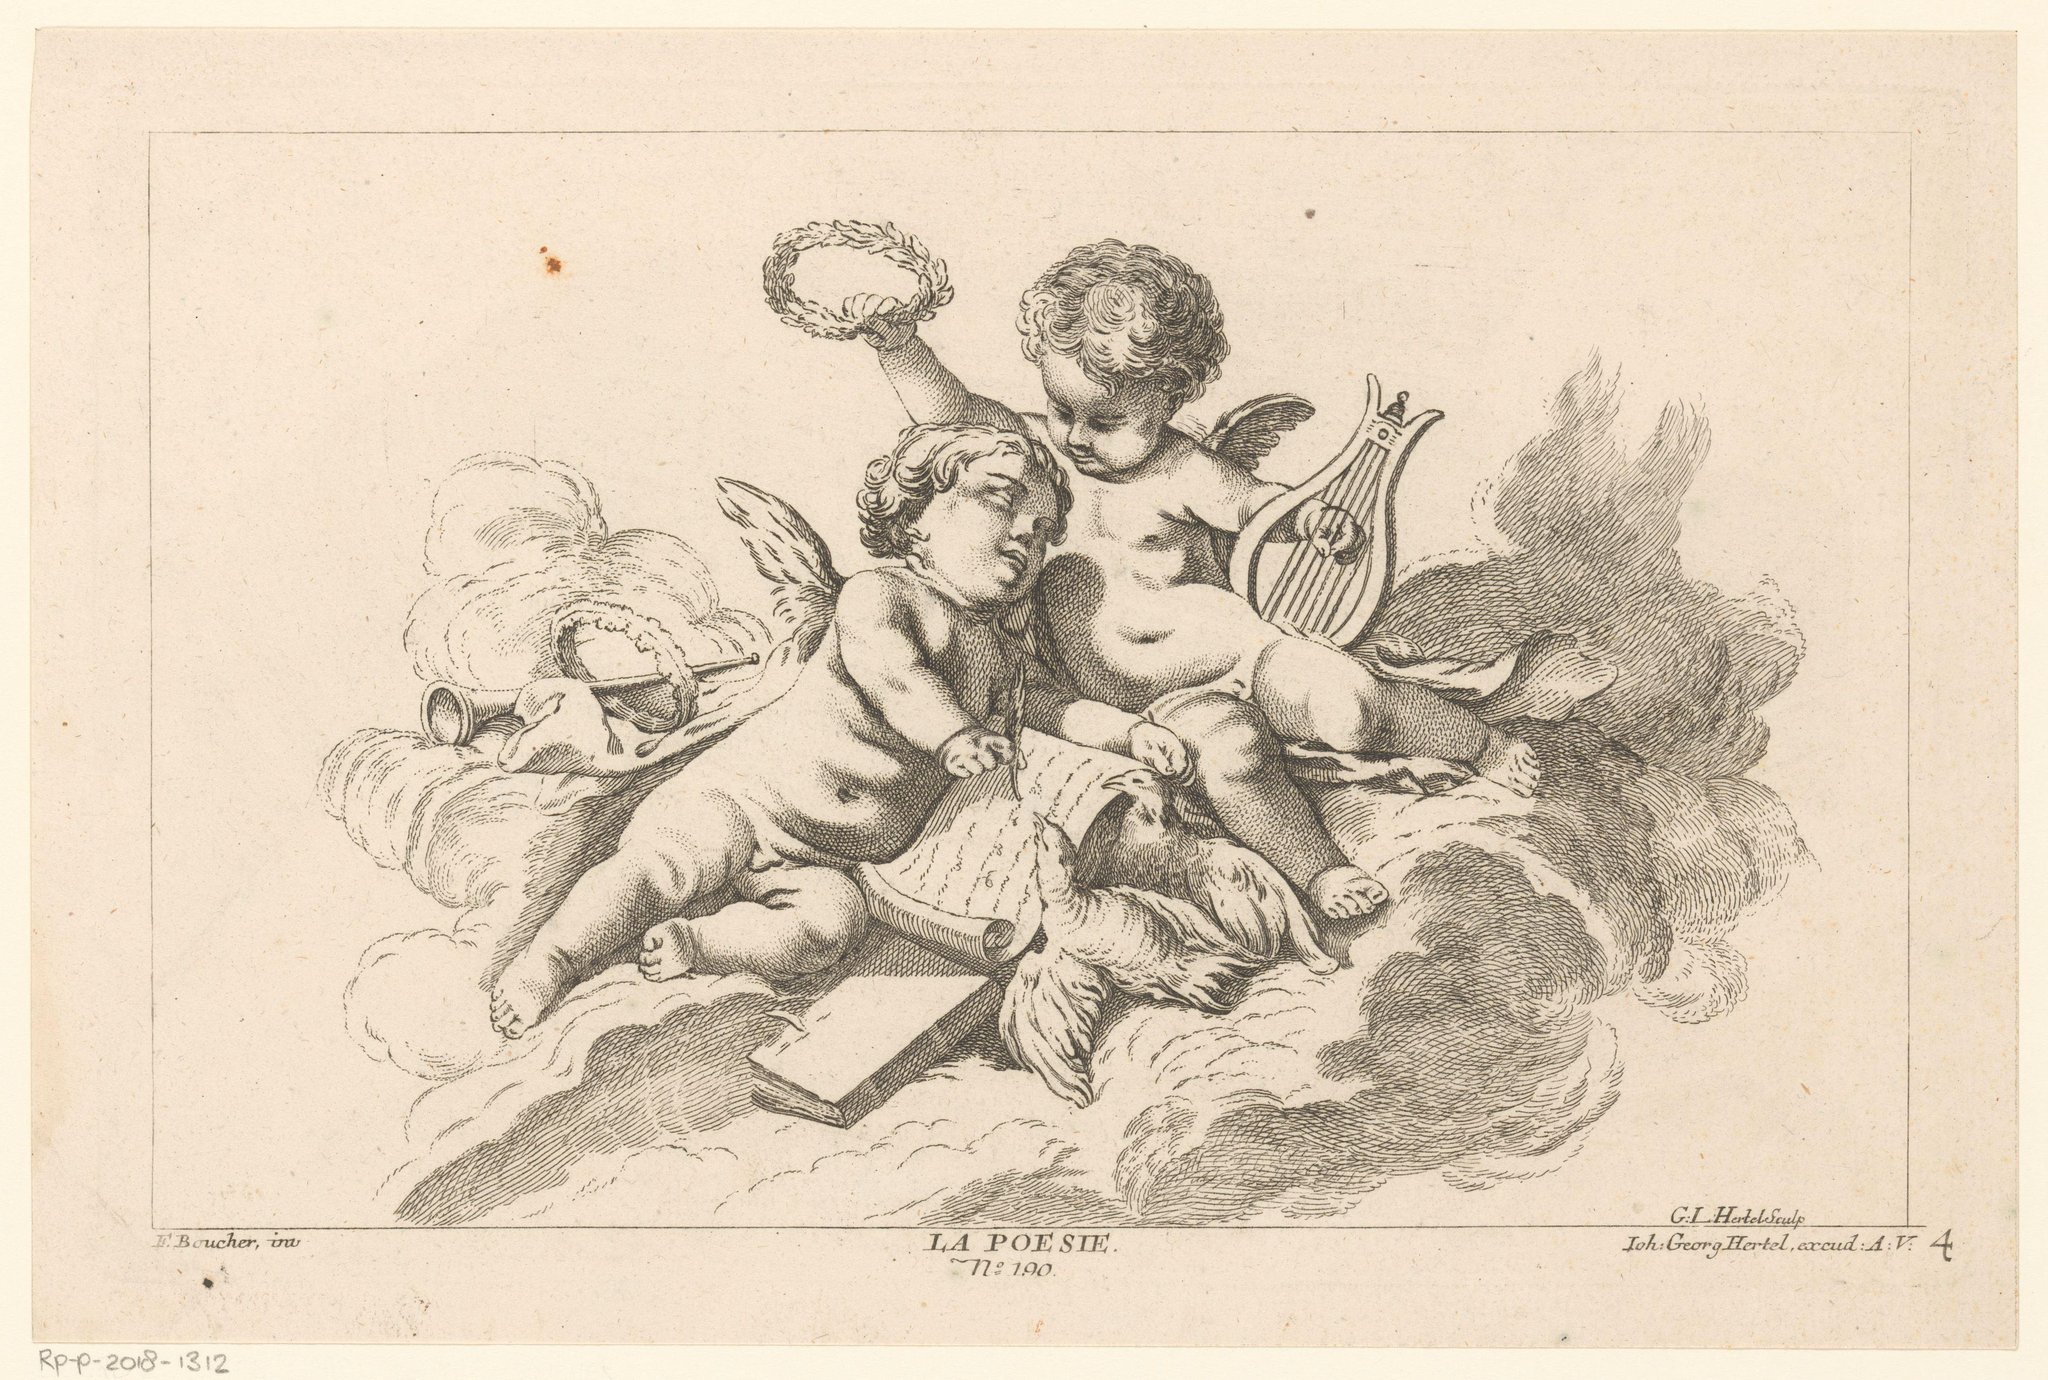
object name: print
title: La Poesie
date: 1750-1778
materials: paper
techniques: engraving, etching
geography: augsburg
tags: symbolic representations, allegories and emblems ~ poetry; 'poesia' (ripa), cupids: 'amores', 'amoretti', 'putti'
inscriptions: collector's mark: Lugt 2228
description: Allegorie van de poëzie. Een putto met een lier lauwert een schrijvende putto naast hem, rondom hen liggen een boek, twee duiven en een bazuin. Uitgeversnummer 190.